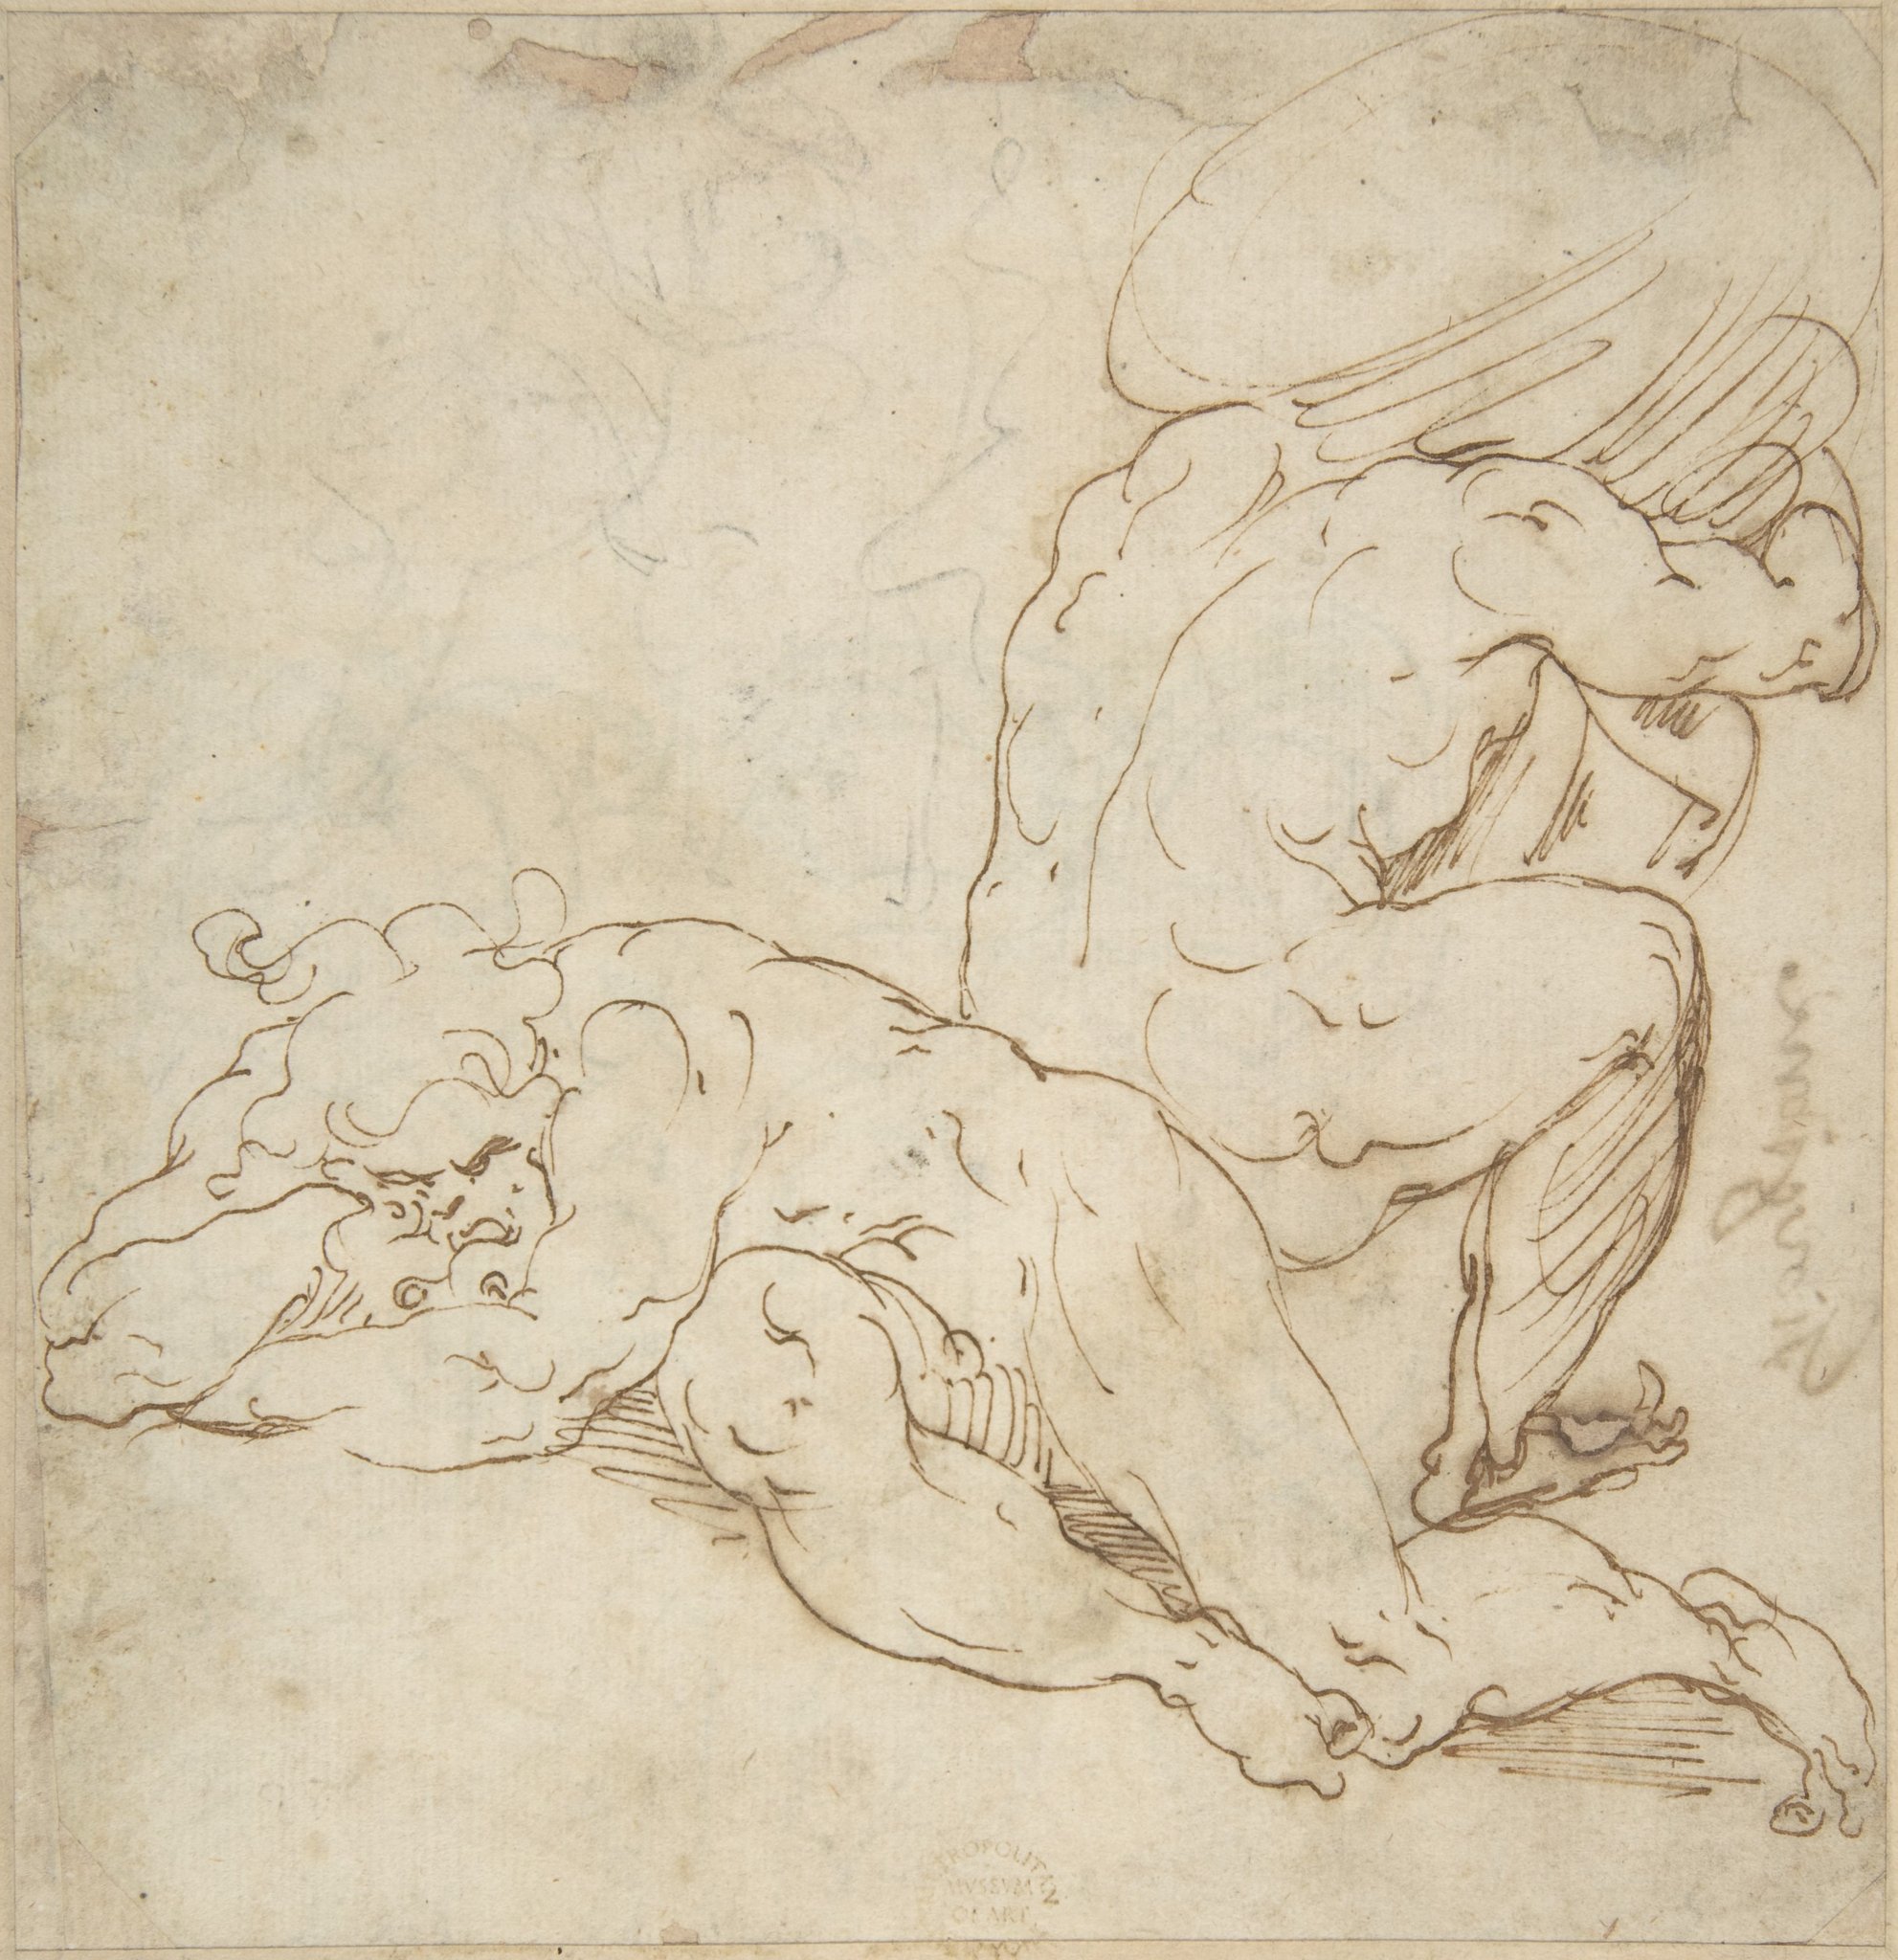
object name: drawing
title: Sisyphus and Tantalus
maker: anonymous, italian, 16th century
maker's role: artist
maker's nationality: italian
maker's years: 1550-1600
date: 1501-1600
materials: ink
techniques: pen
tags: male nudes